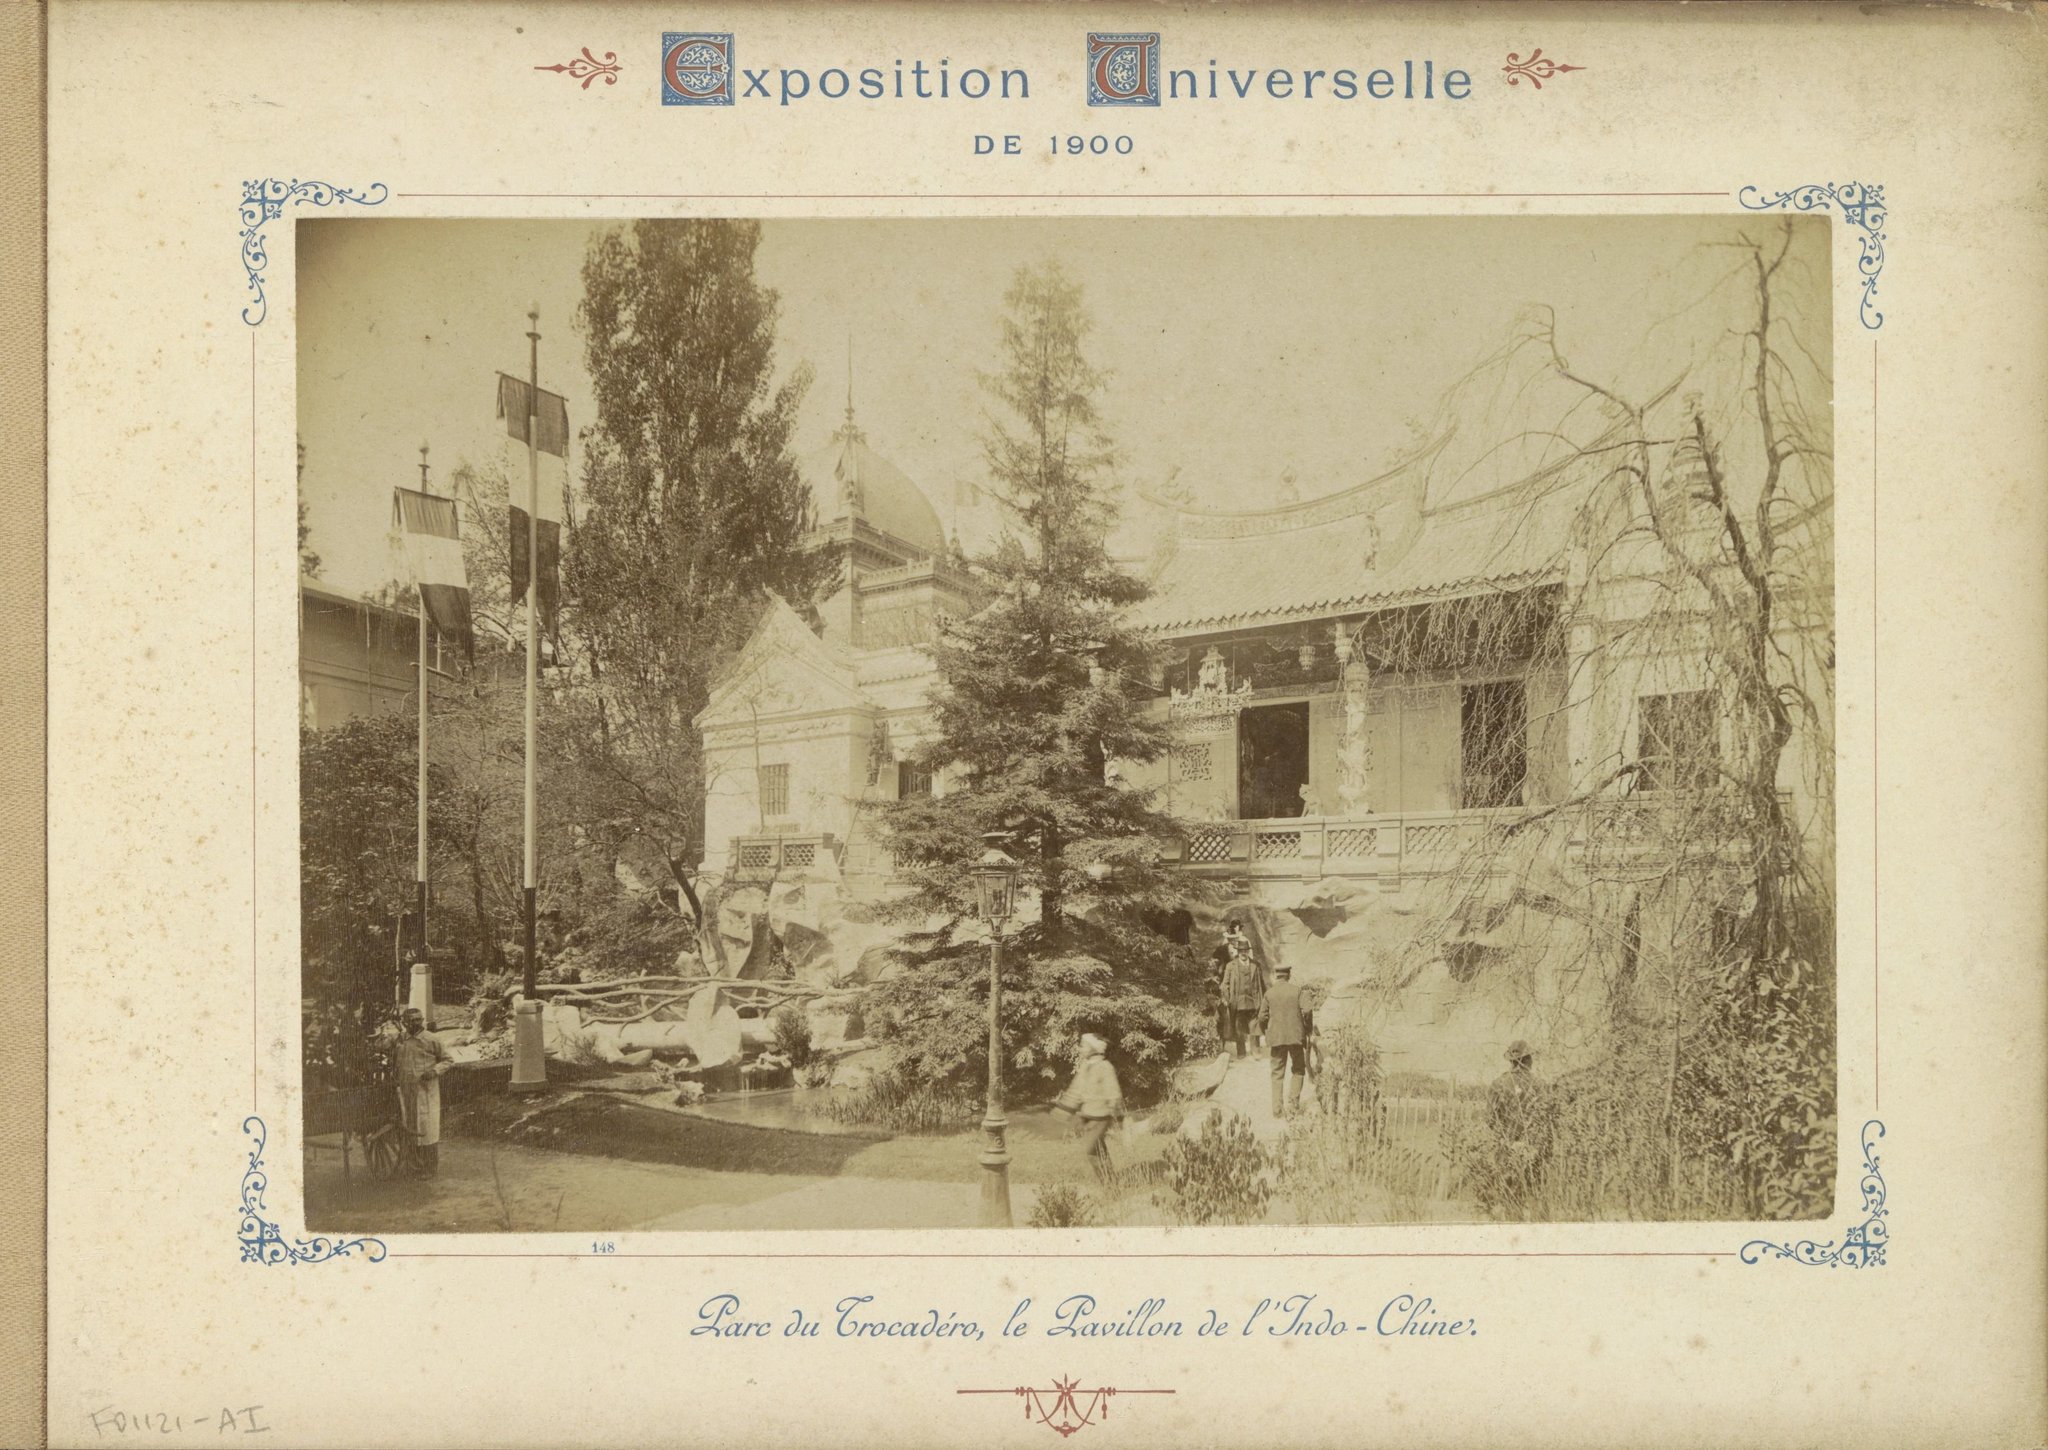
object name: photograph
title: Paviljoen van Indo-China in het Parc de Trocadéro te Parijs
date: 1900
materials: cardboard, paper, photographic support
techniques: albumen print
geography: paris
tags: world fair, world exhibition, palace, paris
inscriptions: number: ‘148’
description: Onderdeel van Fotoalbum met opnames van de Wereldtentoonstelling van 1900 in Parijs.